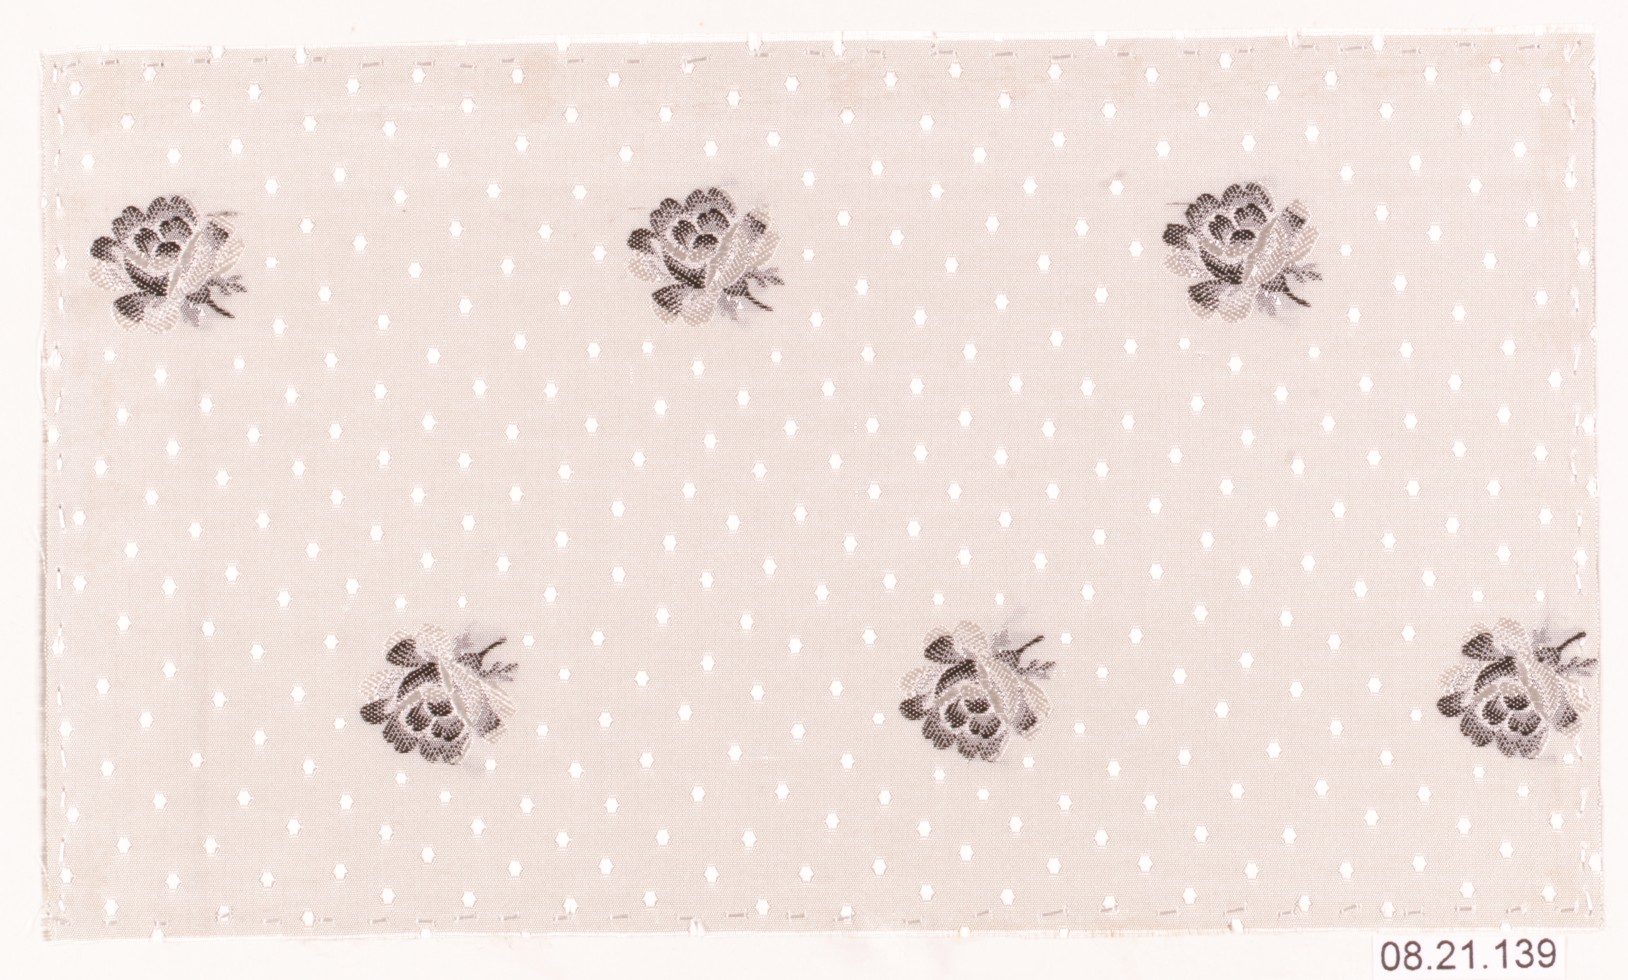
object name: textile sample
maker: Anonymous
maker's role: designer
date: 1900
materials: silk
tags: flowers